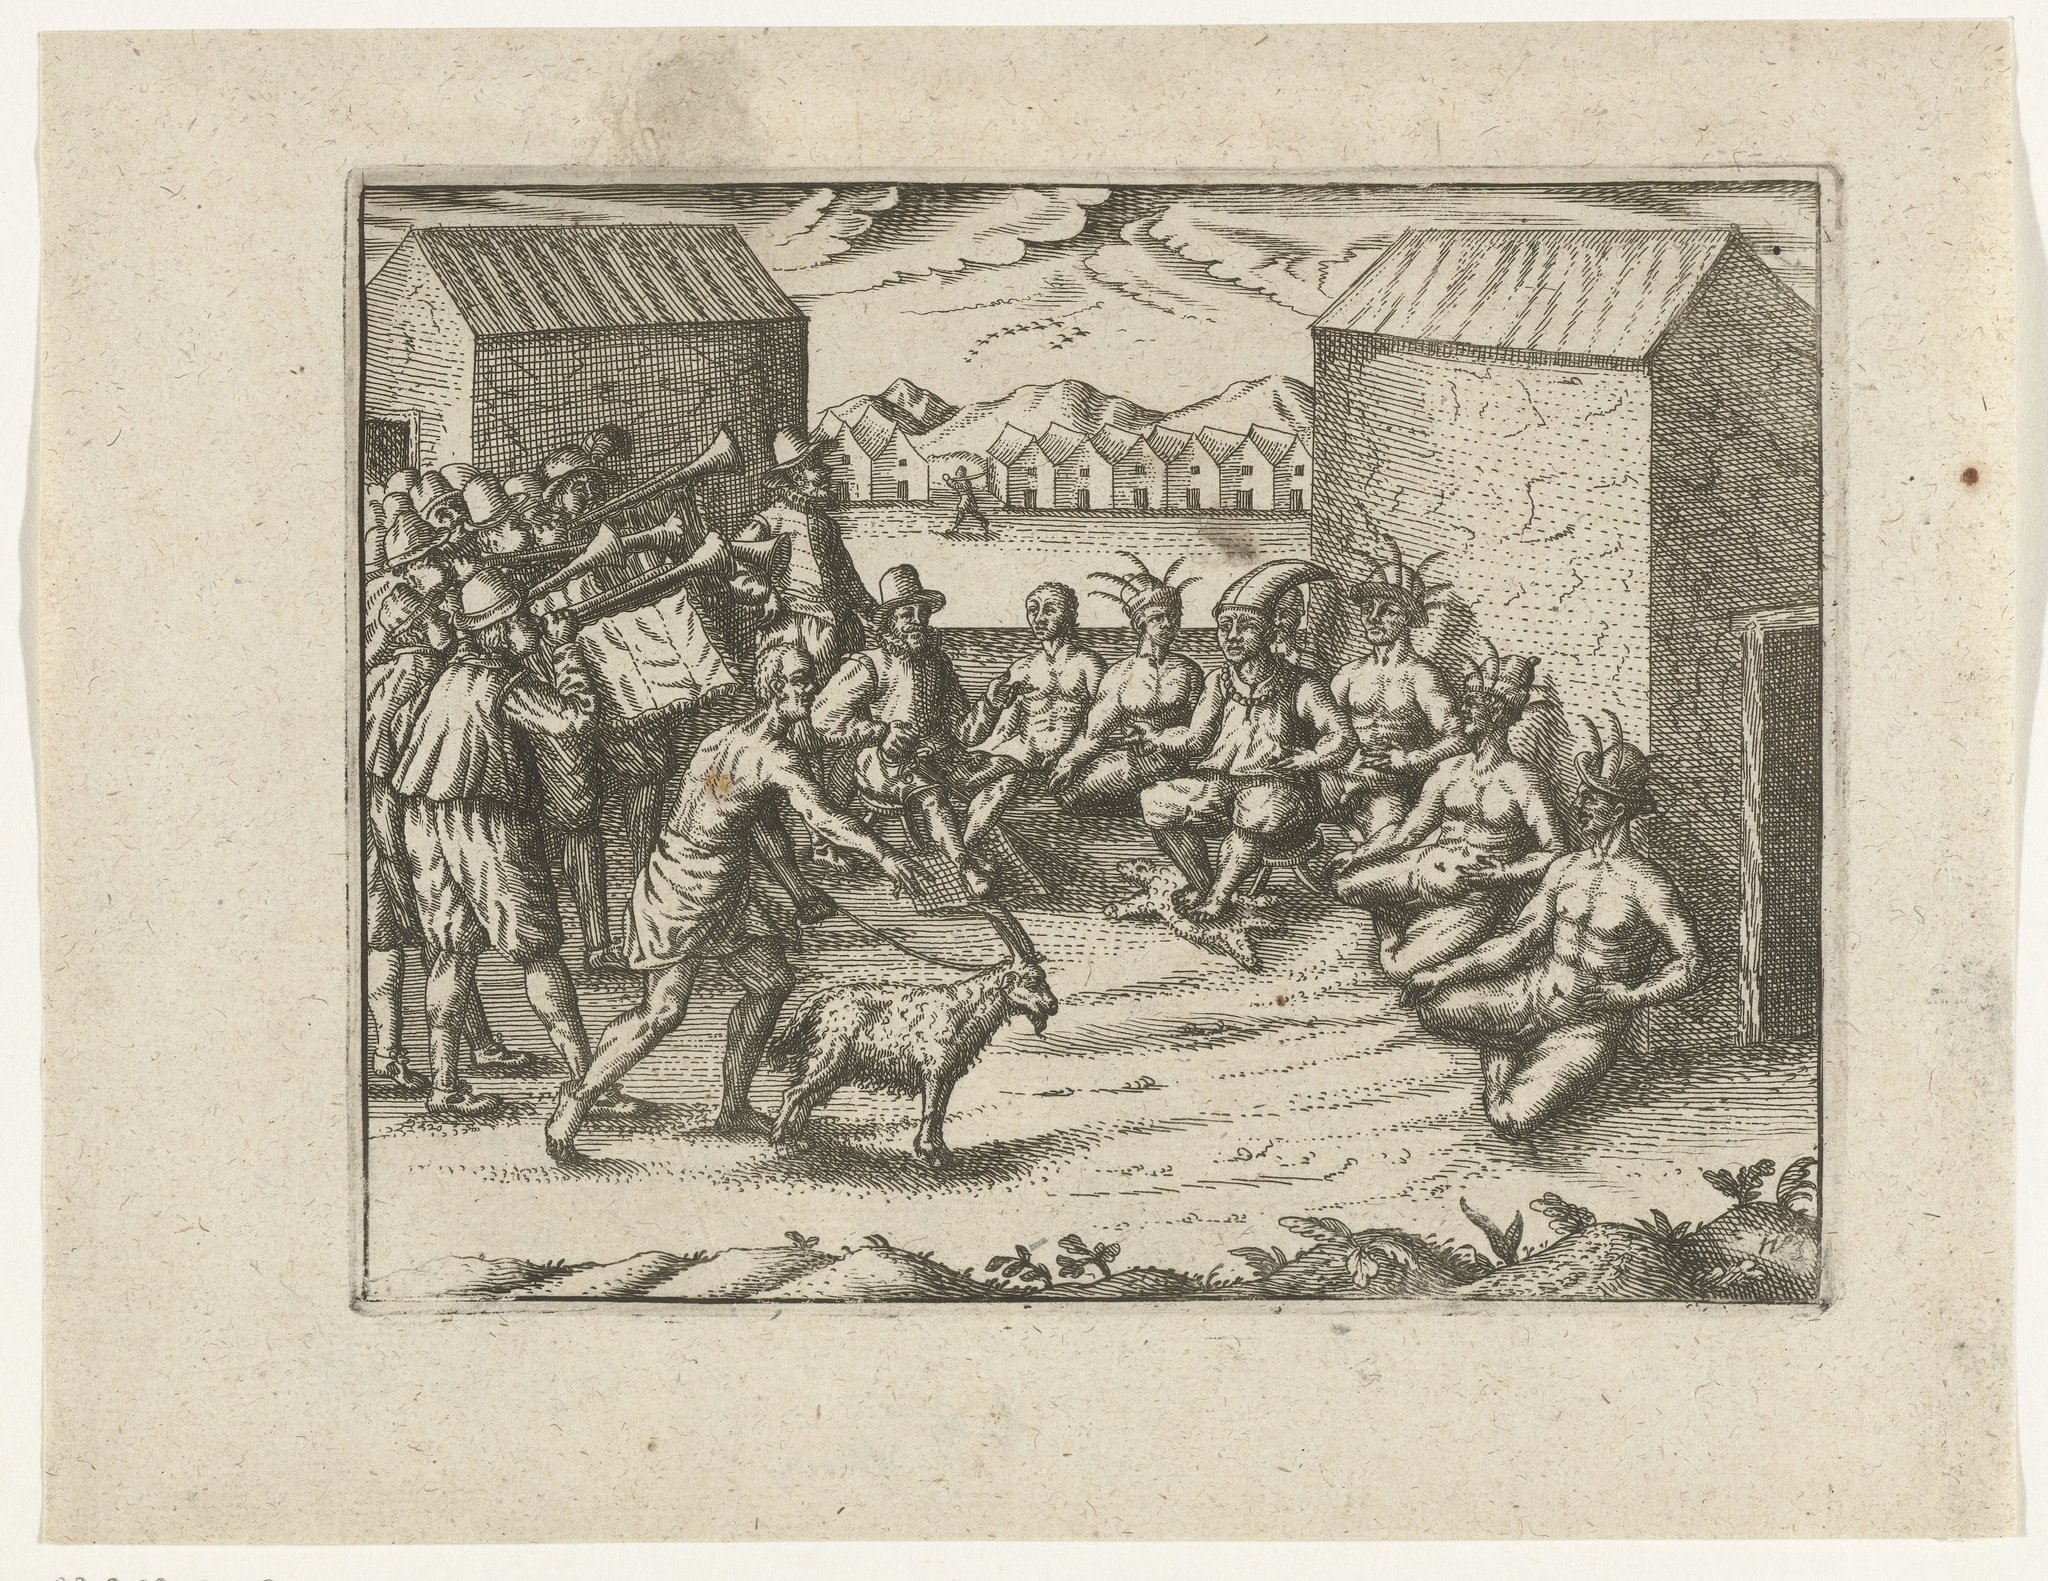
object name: print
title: Bezoek aan een Afrikaanse koning, 1598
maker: Anonymous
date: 1617-1619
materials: paper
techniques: engraving, etching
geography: northern netherlands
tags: sri lanka, landscapes in tropical and sub-tropical regions, exploration, expedition, voyage of discovery, guinea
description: De oorspronkelijke illustraties eerst gebruikt in: Barent Jansz Potgieter, Zacharias Heyns, Wijdtloopigh verhael van tgene de vijf schepen (die int jaer 1598 tot Rotterdam toegherust werden om door de Straet Magellana haren handel te dryven) wedervaren is, tot den 7. September 1599 toe, op welcken dagh capiteyn Sebald de Weert met twee schepen door onweder van de vlote versteken werdt. Ende voort in wat groot gevaer ... hy ... ghelegen heeft, tot dat hy ... weder naar huys heeft moeten keeren plaat, Z. Heyns, Amsterdam 1600. Deze kopieën gebruikt in: Oost-Indische ende West-Indische voyagien, Michiel Colijn, Amsterdam 1619 en later in: Kort ende waerachtigh Verhael van 't gheene seeckere vijf Schepen, van Rotterdam, in 't jaer 1598, den 27 Junij nae de Straet Magaljanes varende, over-ghekomen is. Opgenomen in: I. Commelin, Begin ende voortgangh, van de Vereenighde Nederlantsche Geoctroyeerde Oost-Indische Compagnie, J. Janssonius, Amsterdam 1646. Genummerd: No. 3.